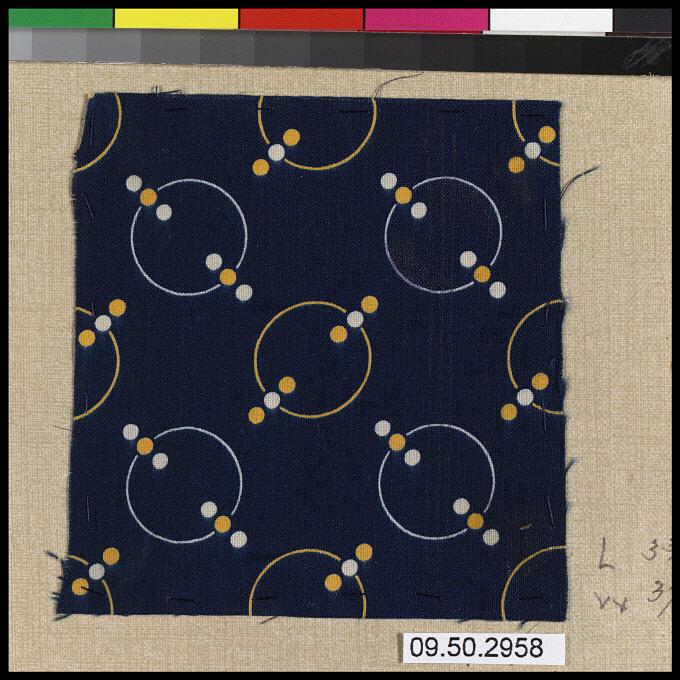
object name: piece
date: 1801-1900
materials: cotton